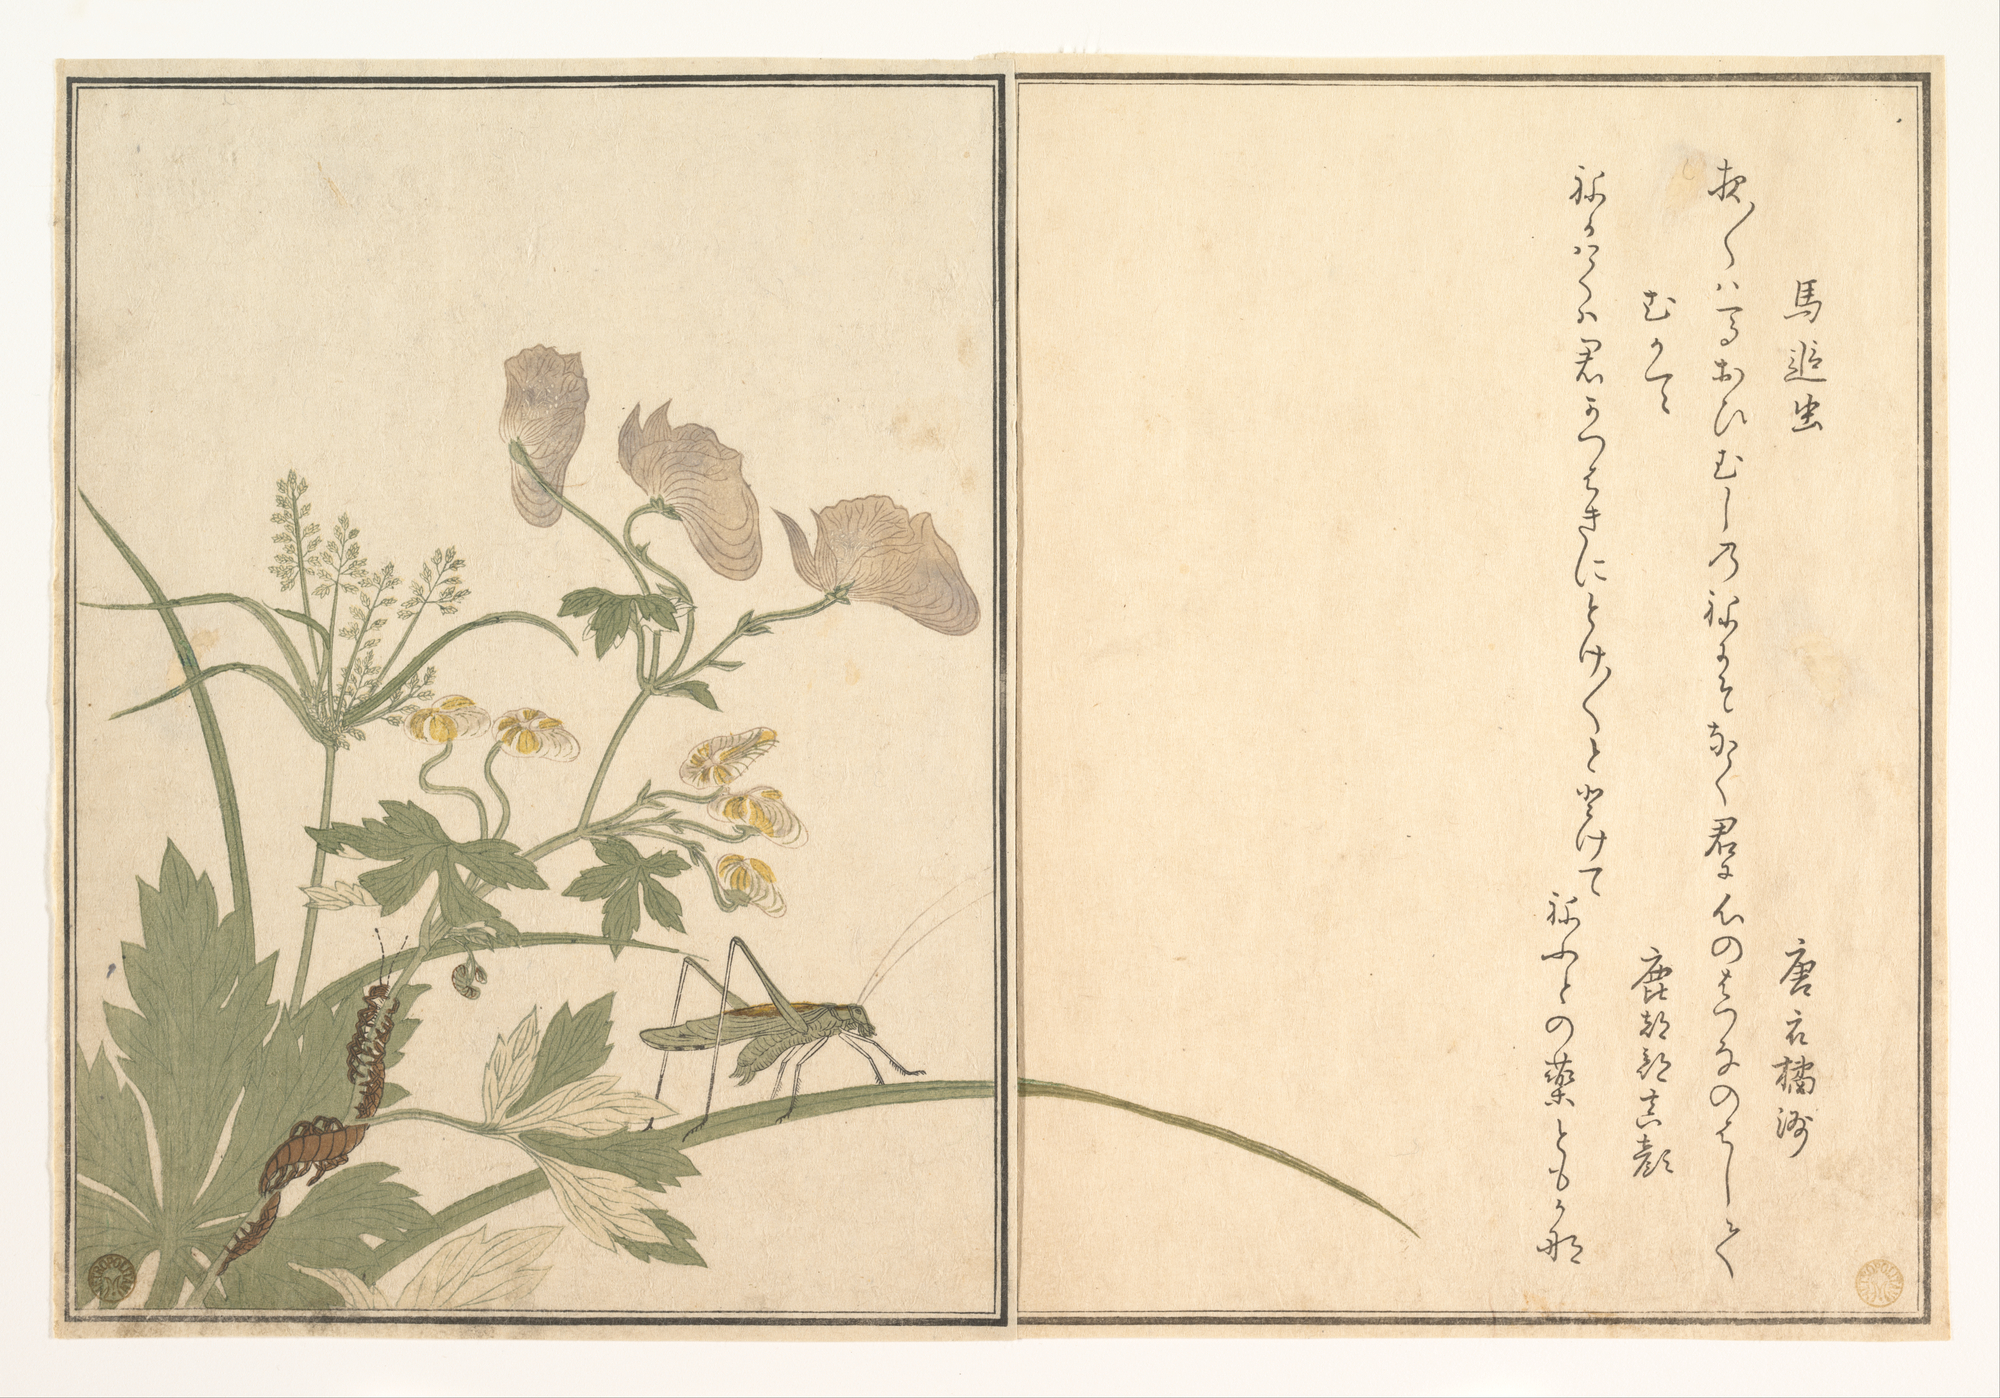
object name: woodblock print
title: Katydid (Umaoi-mushi); Centipede, (Mukade), from the Picture Book of Crawling Creatures (Ehon mushi erami)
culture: japanese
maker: kitagawa utamaro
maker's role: artist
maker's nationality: japanese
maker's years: 1754-1806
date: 1788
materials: ink, paper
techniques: woodblock print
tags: insects,flowers,plants